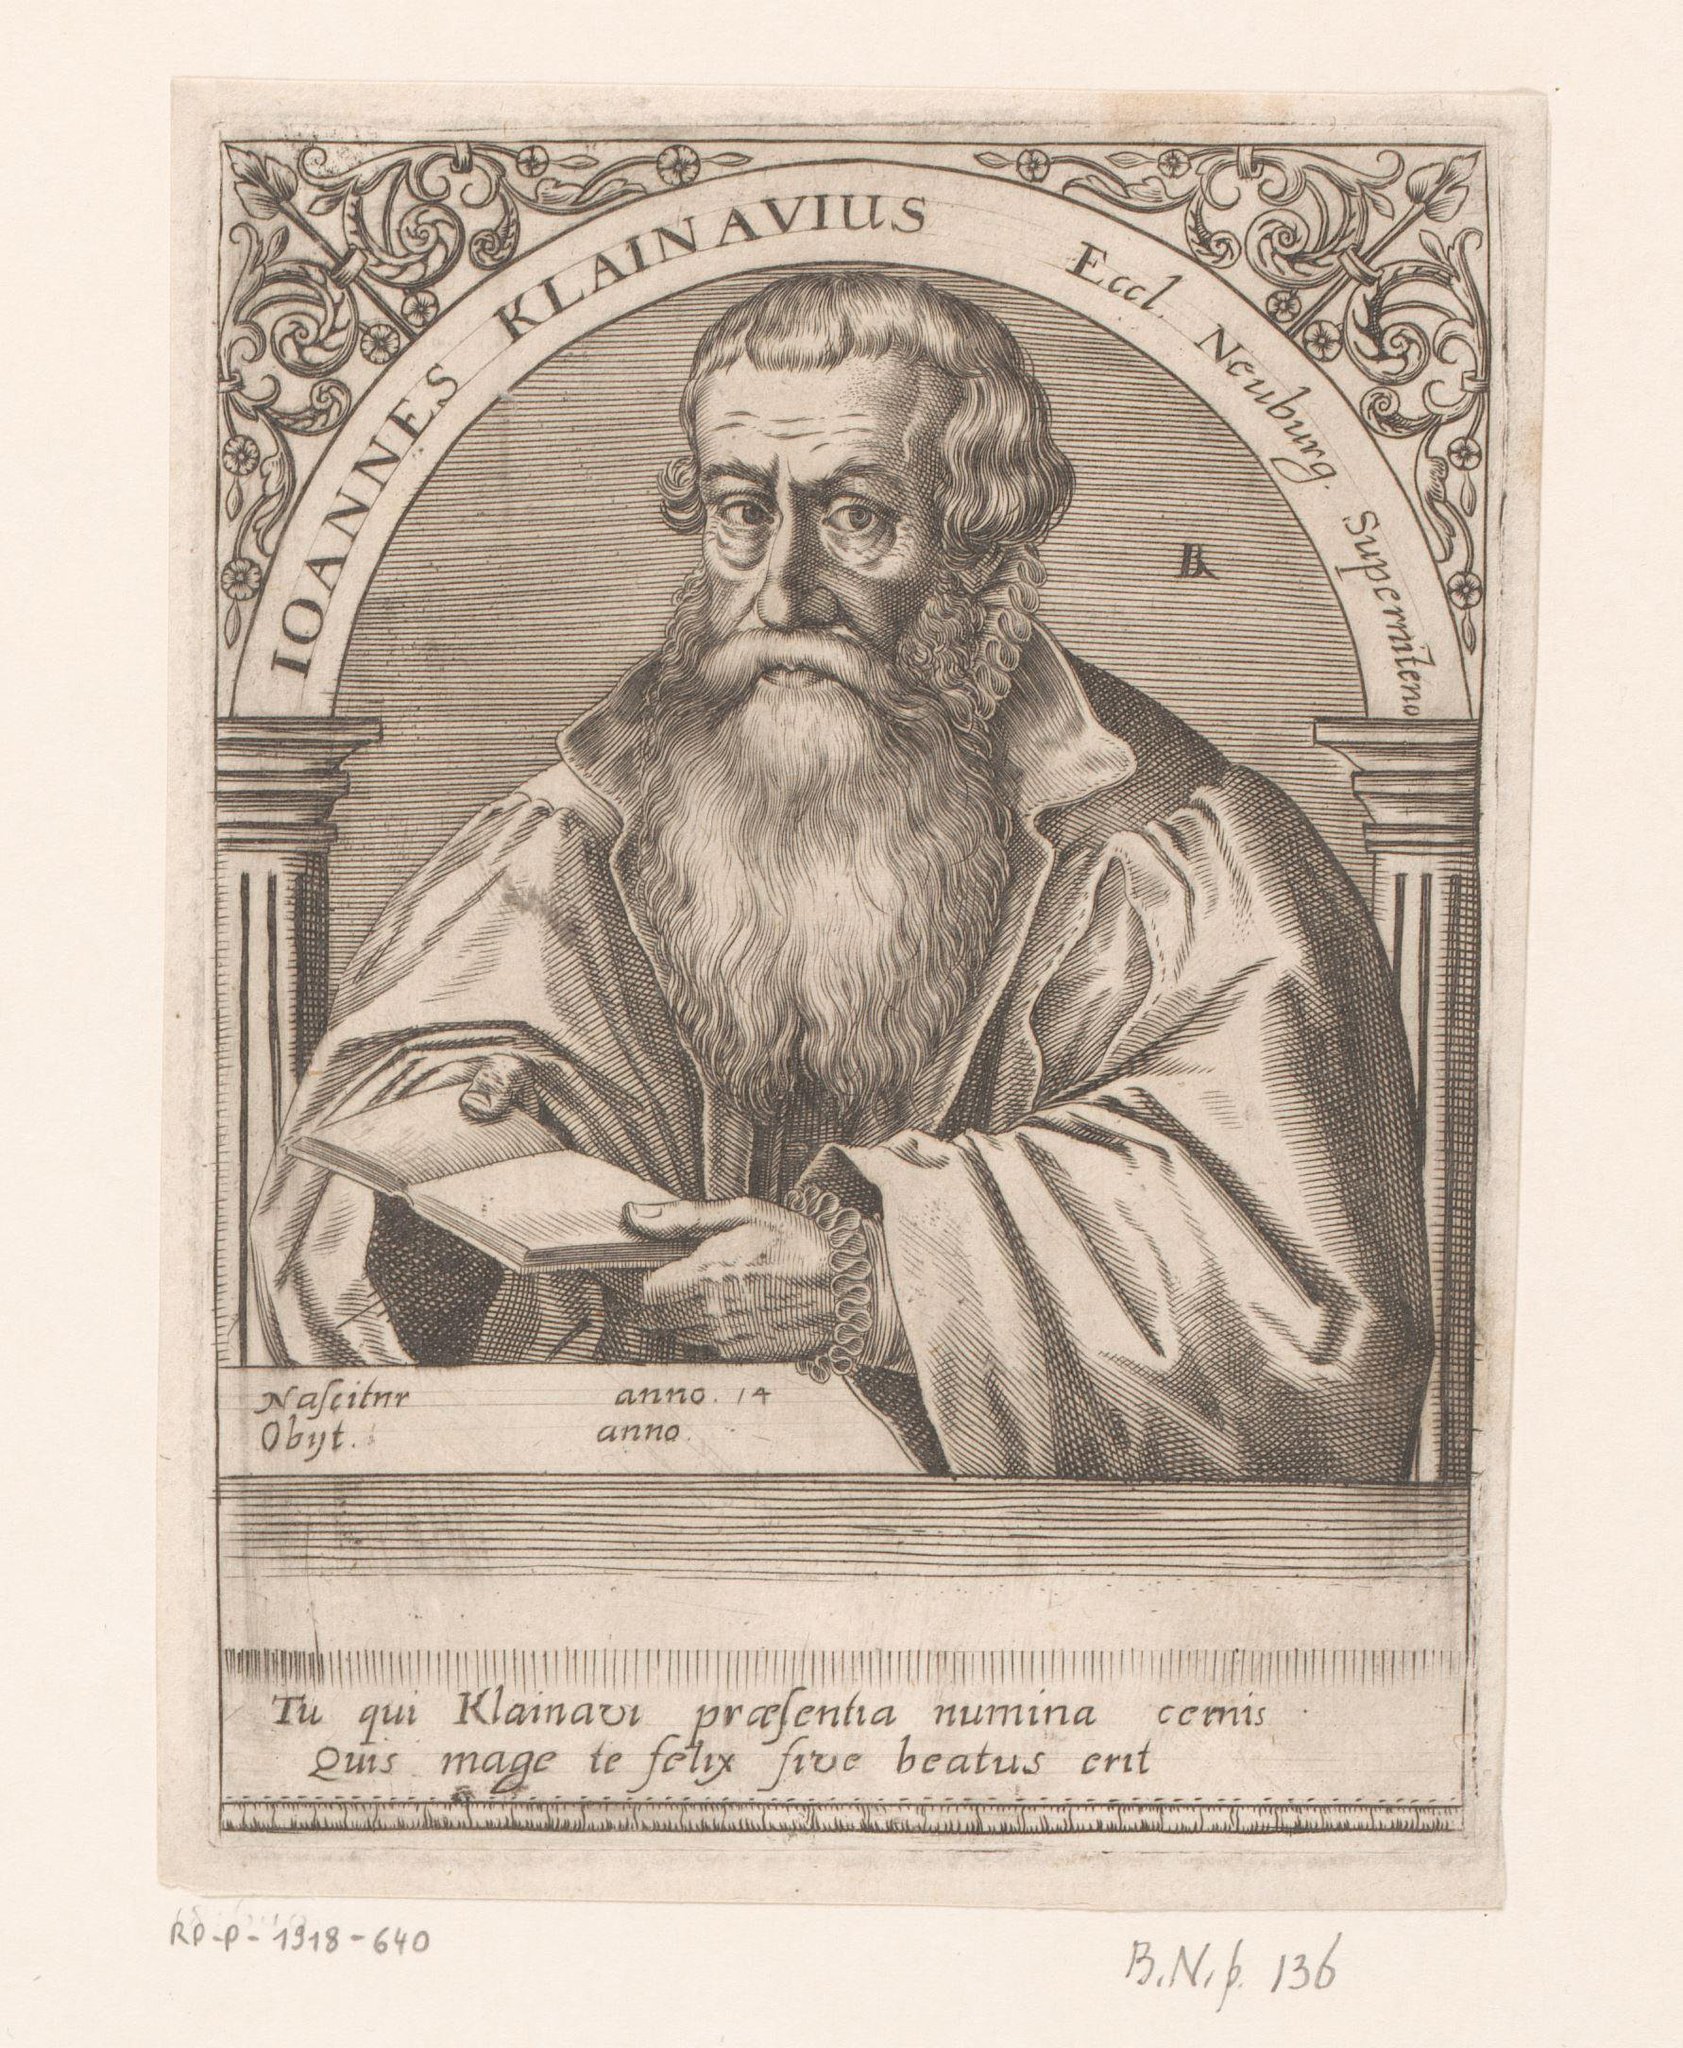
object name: print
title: Portret van Johann Klainau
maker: robert boissard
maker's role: print maker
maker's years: 1570-1611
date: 1597-1599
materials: paper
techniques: engraving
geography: france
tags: historical persons, book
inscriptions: collector's mark: Lugt 2233